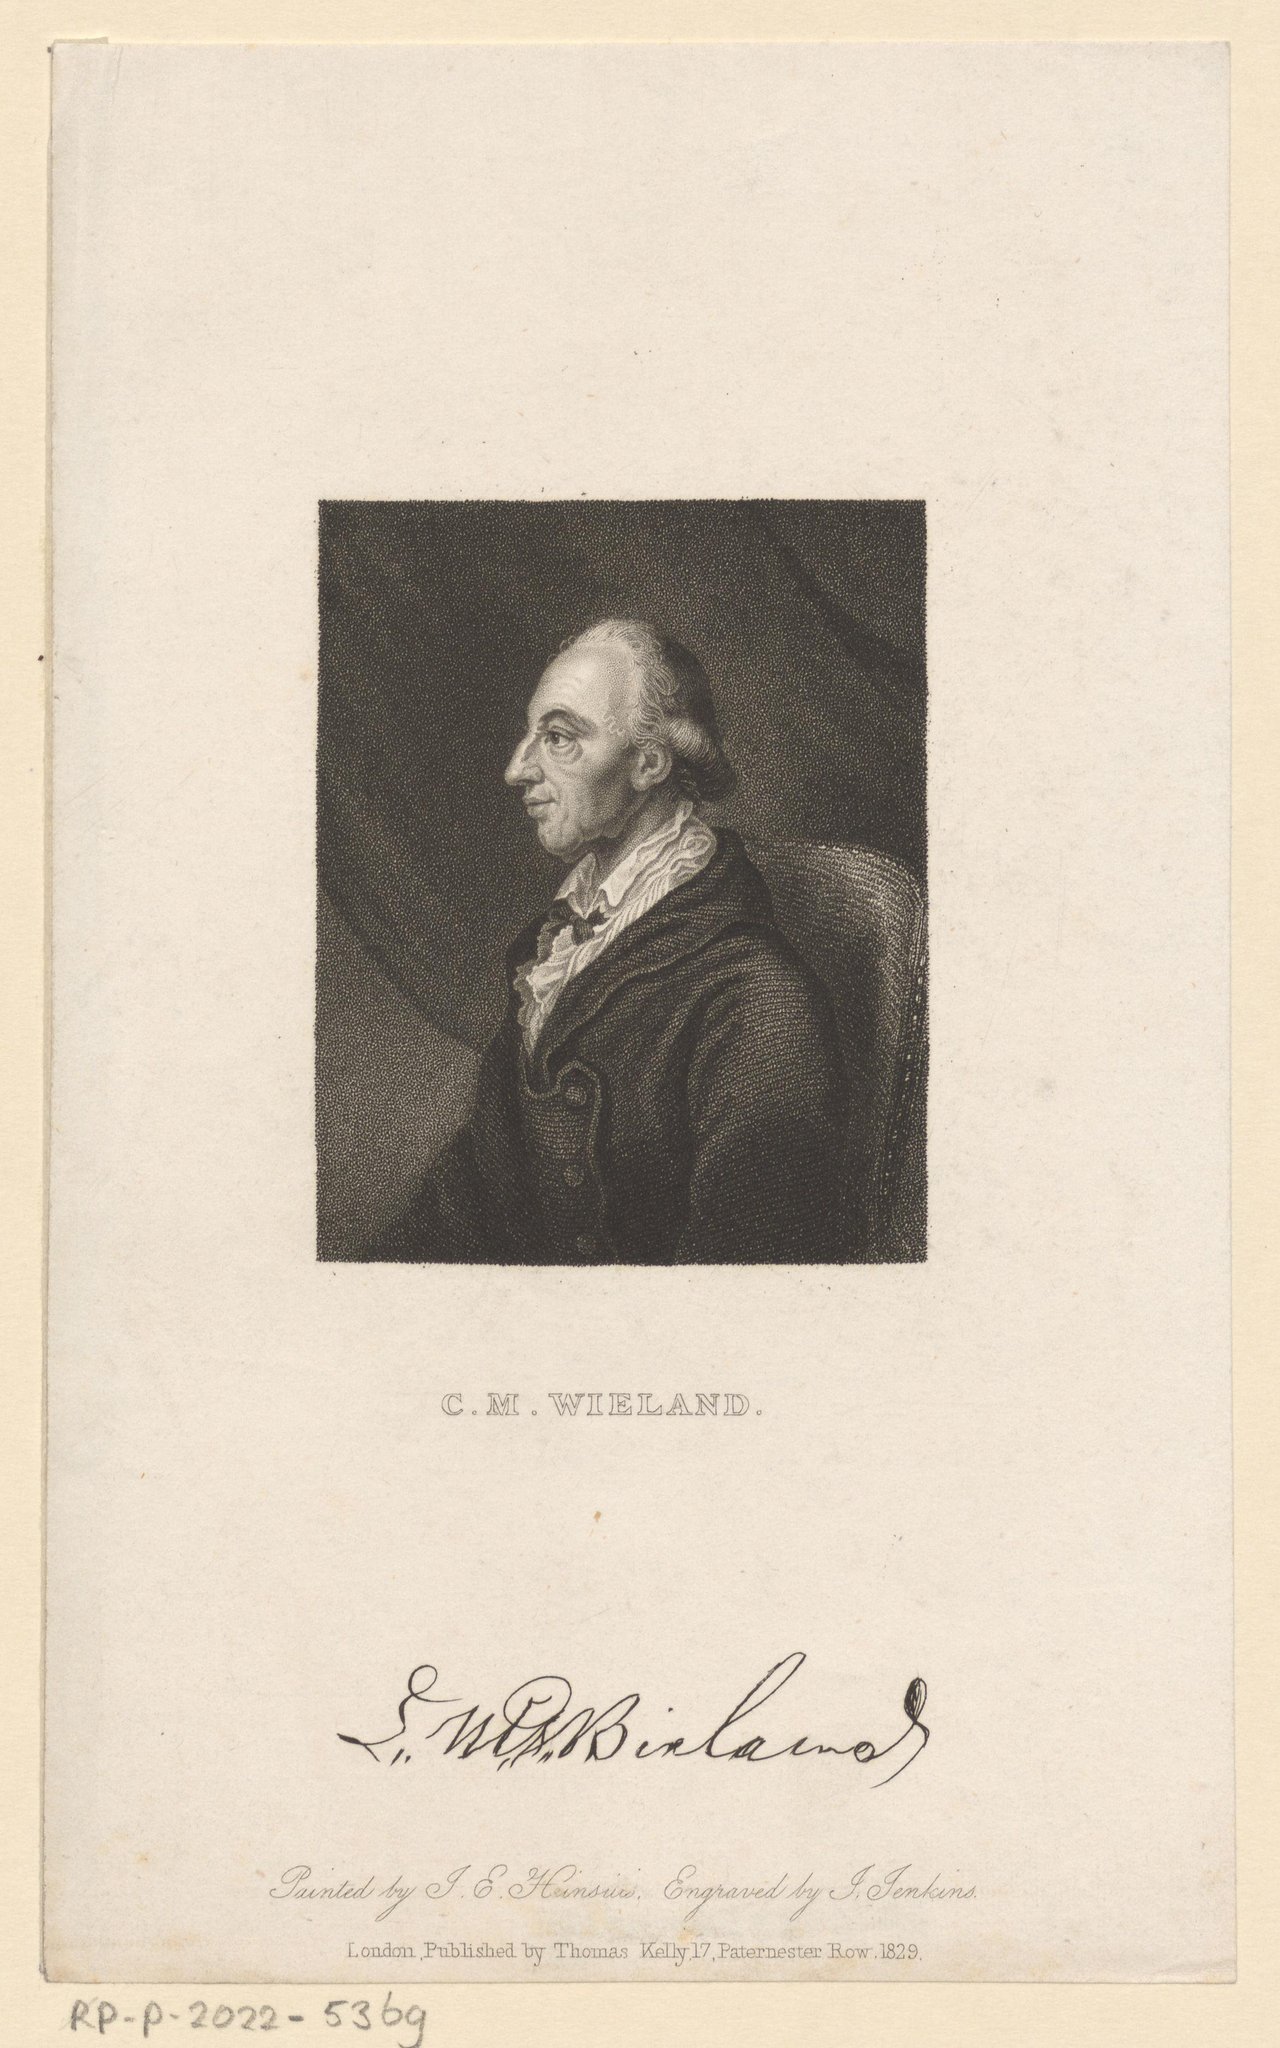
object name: print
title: Portret van Christoph Martin Wieland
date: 1829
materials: paper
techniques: etching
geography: london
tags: publisher, christoph martin wieland, historical persons, writer, poet, author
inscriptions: number: ‘5733’